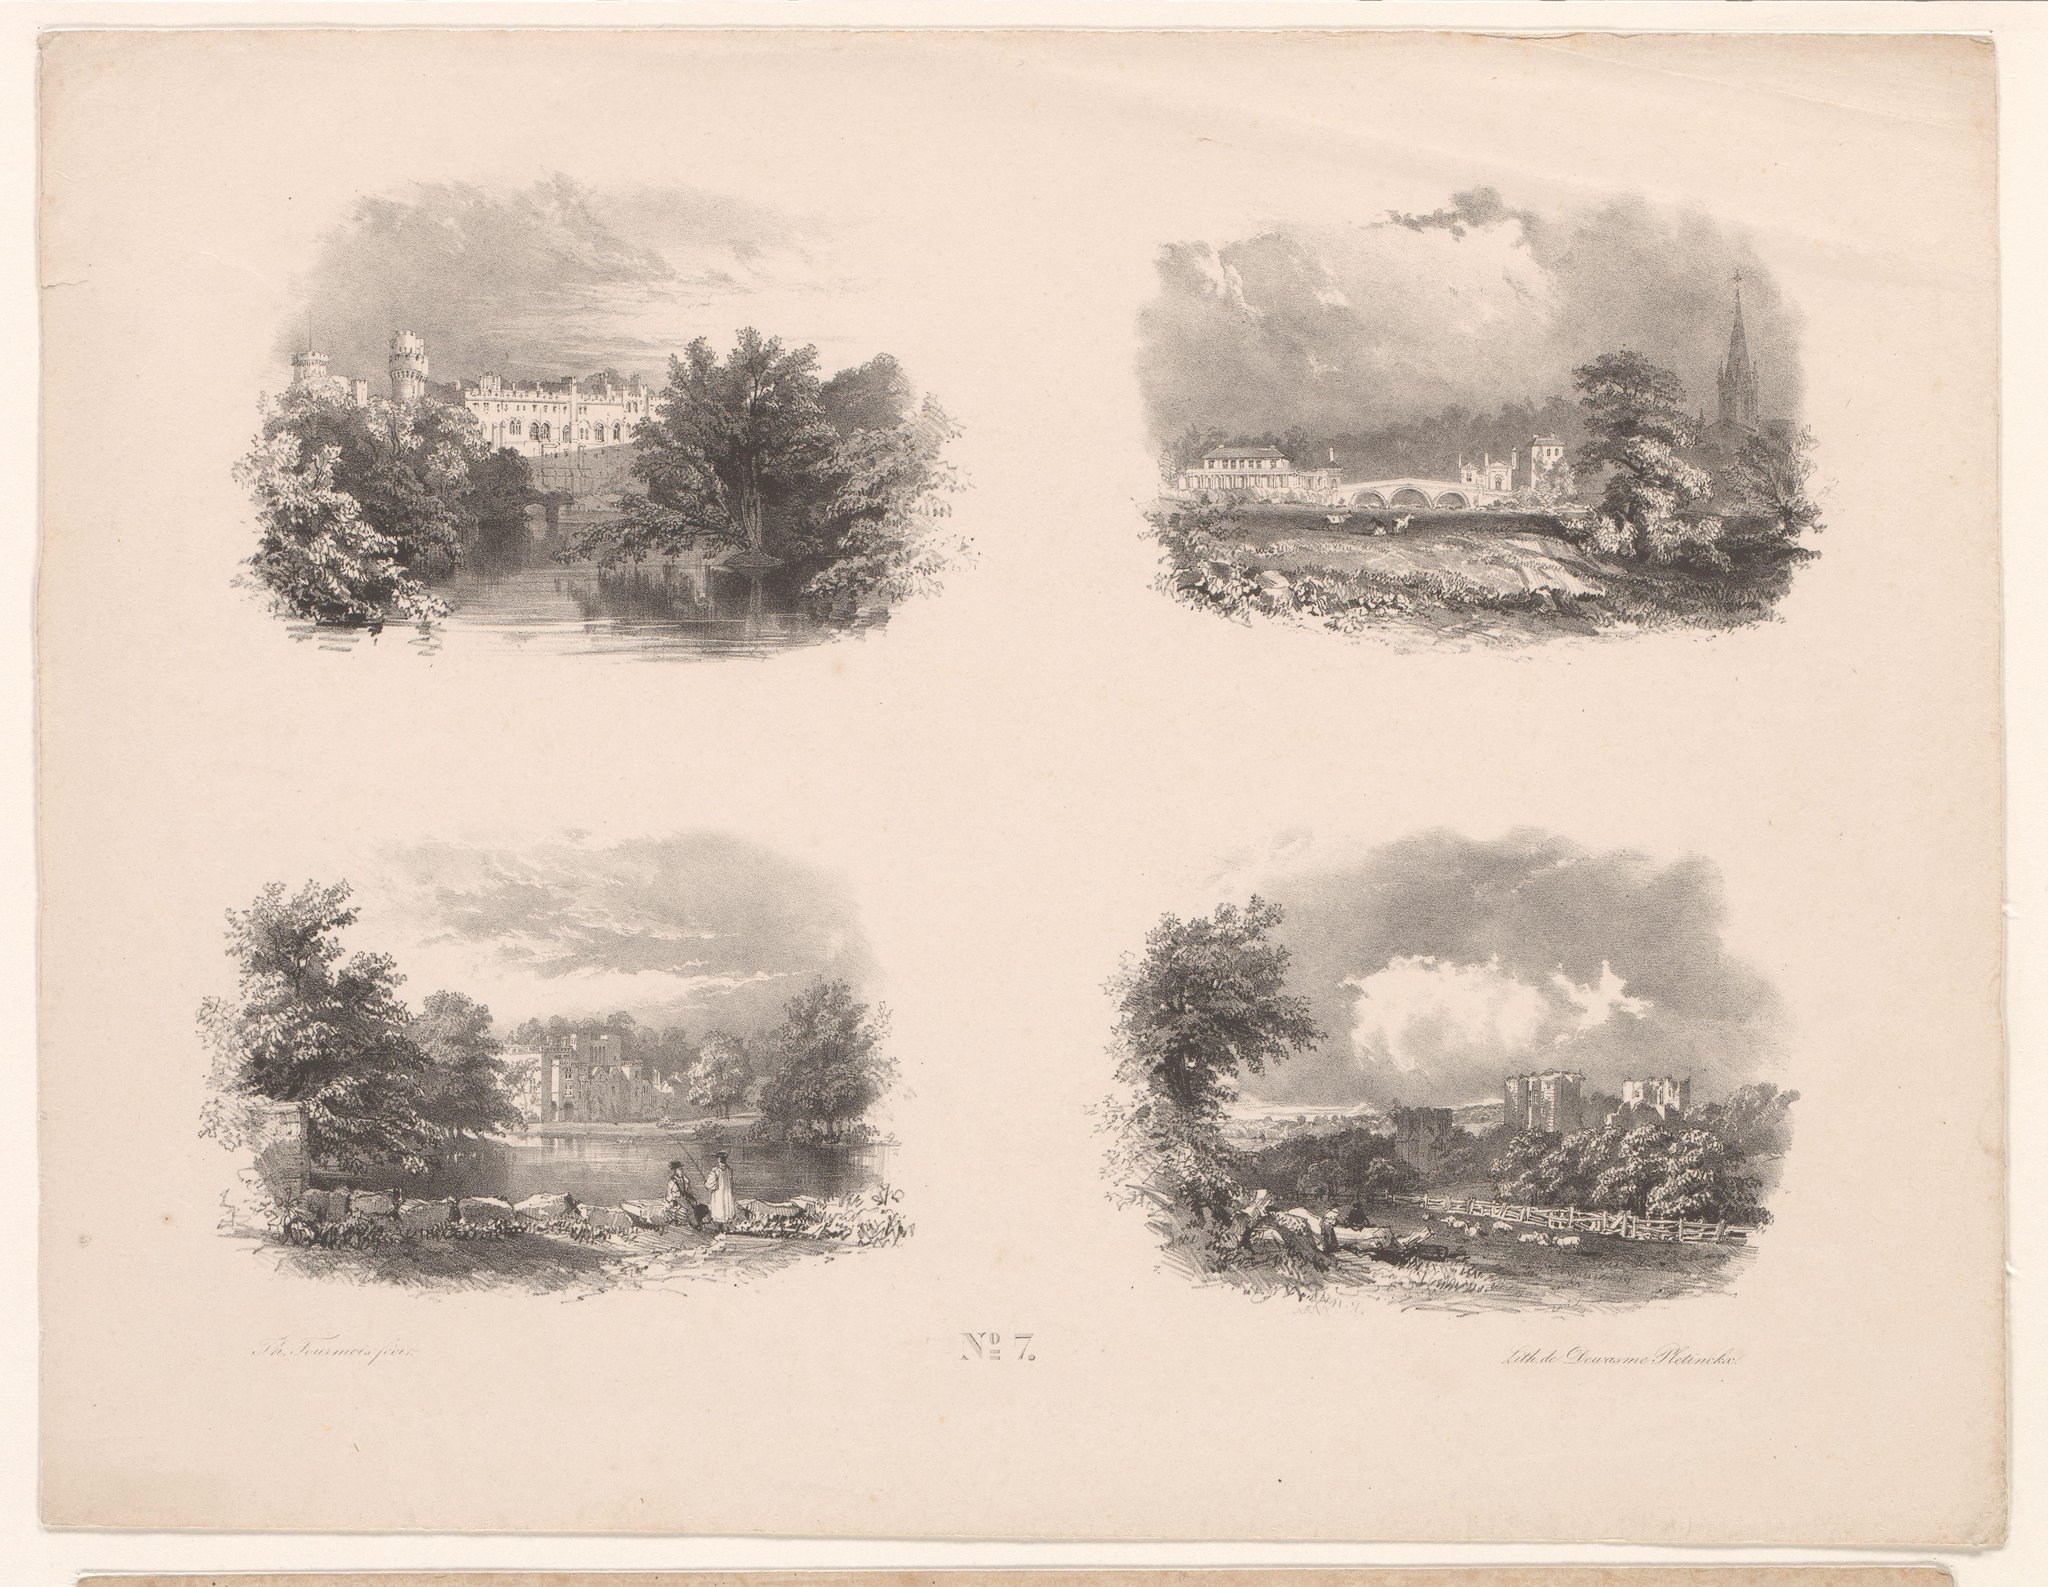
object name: print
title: Vier landschappen met monumentale bebouwing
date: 1827-1851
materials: paper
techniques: lithograph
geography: brussels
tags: city-view, and landscape with man-made constructions, civic architecture; edifices; dwellings